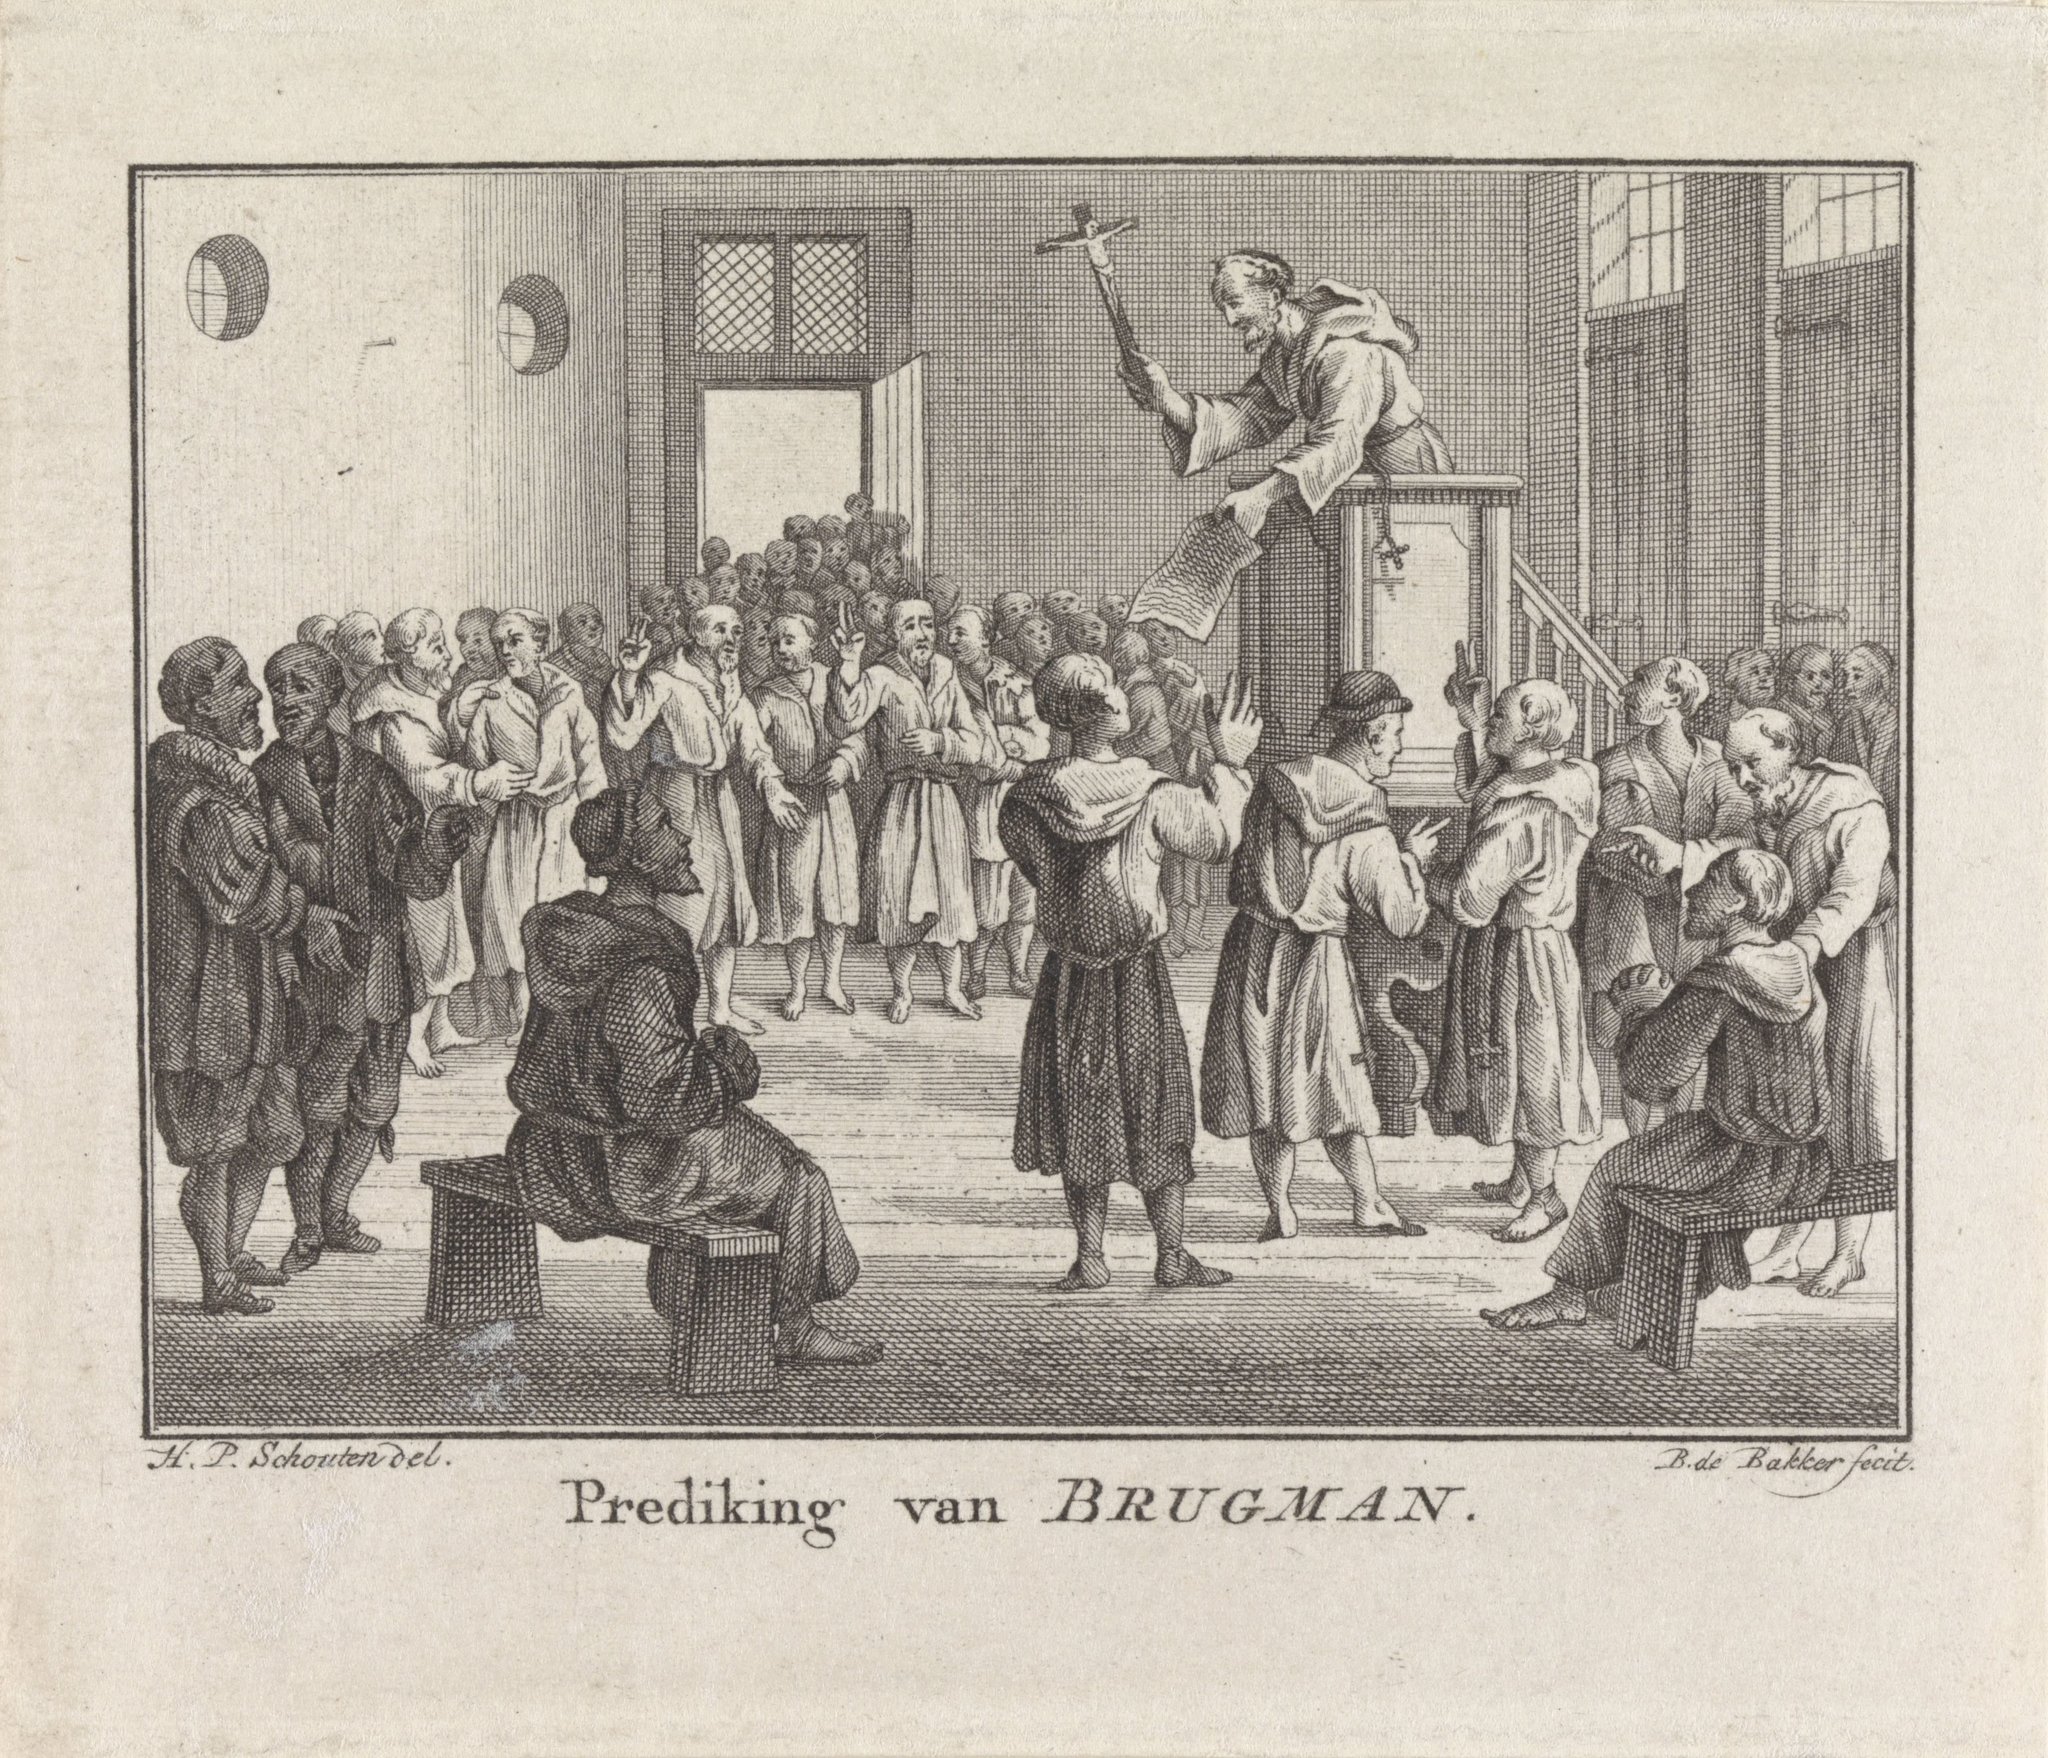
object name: print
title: Prediking van volksprediker Johannes Brugman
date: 1782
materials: paper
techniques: engraving, etching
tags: preaching (in general)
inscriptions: collector's mark: Lugt 2228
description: Volksprediker Johannes Brugman staat gekleed als franciscaner monnik op een kansel met crucifix in de hand. Hij bemiddelt tussen schieringers en vetkopers in Friesland (1463).